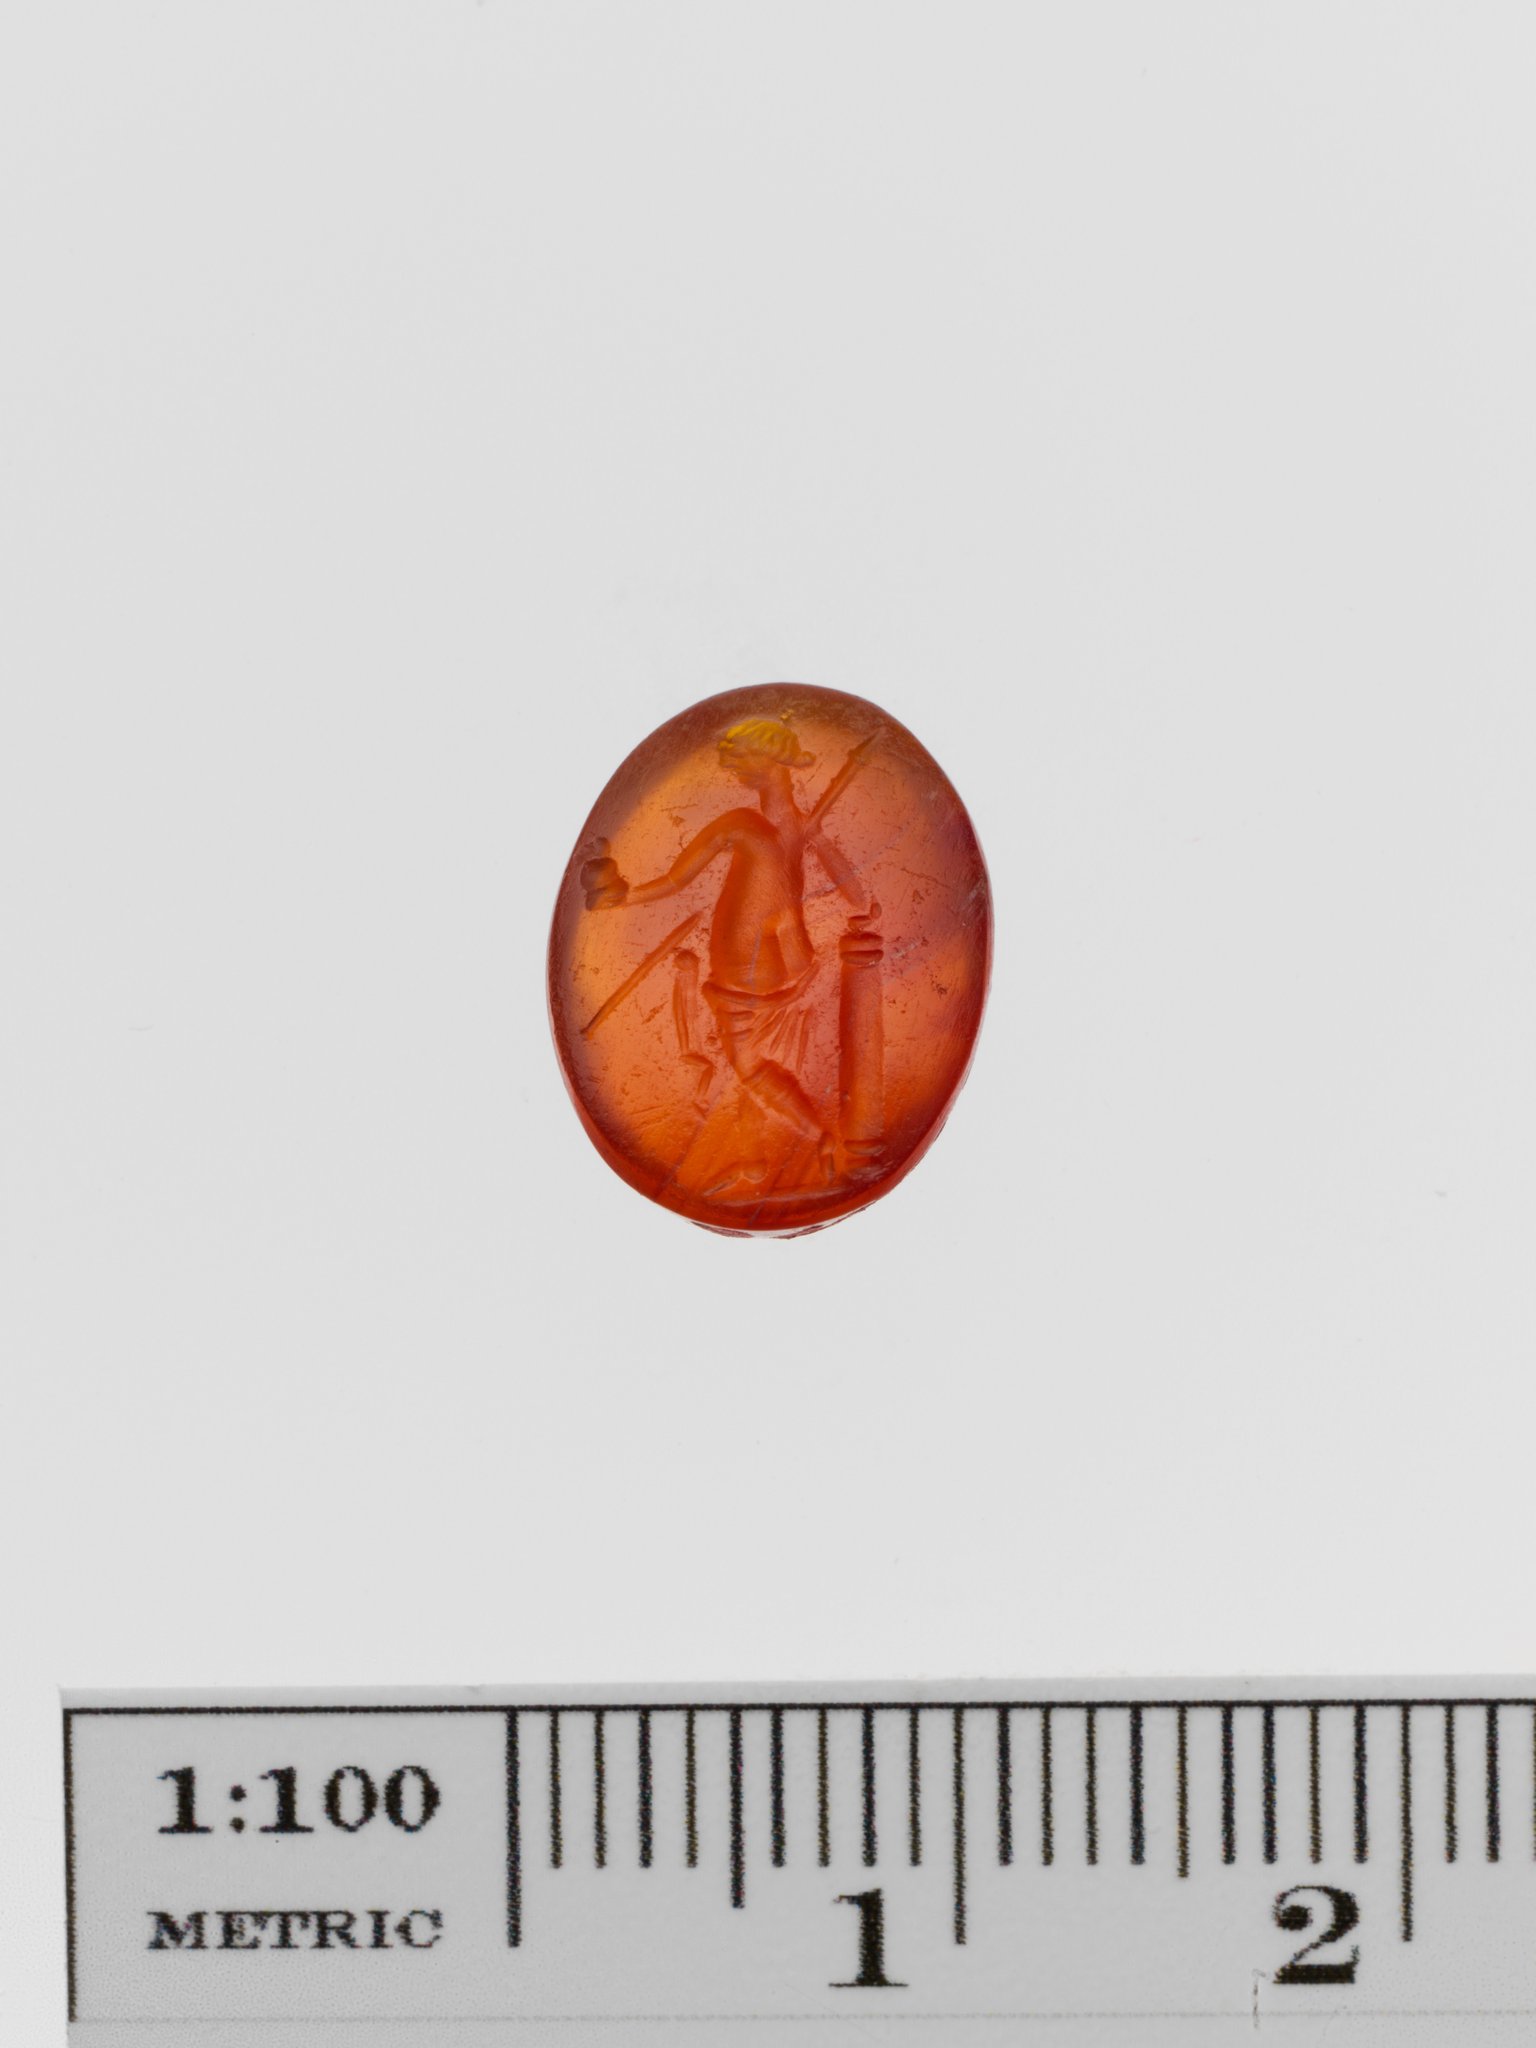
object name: intaglio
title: Carnelian ring stone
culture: roman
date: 100 BCE-300 CE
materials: gemstone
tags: helmets,spears,aphrodite